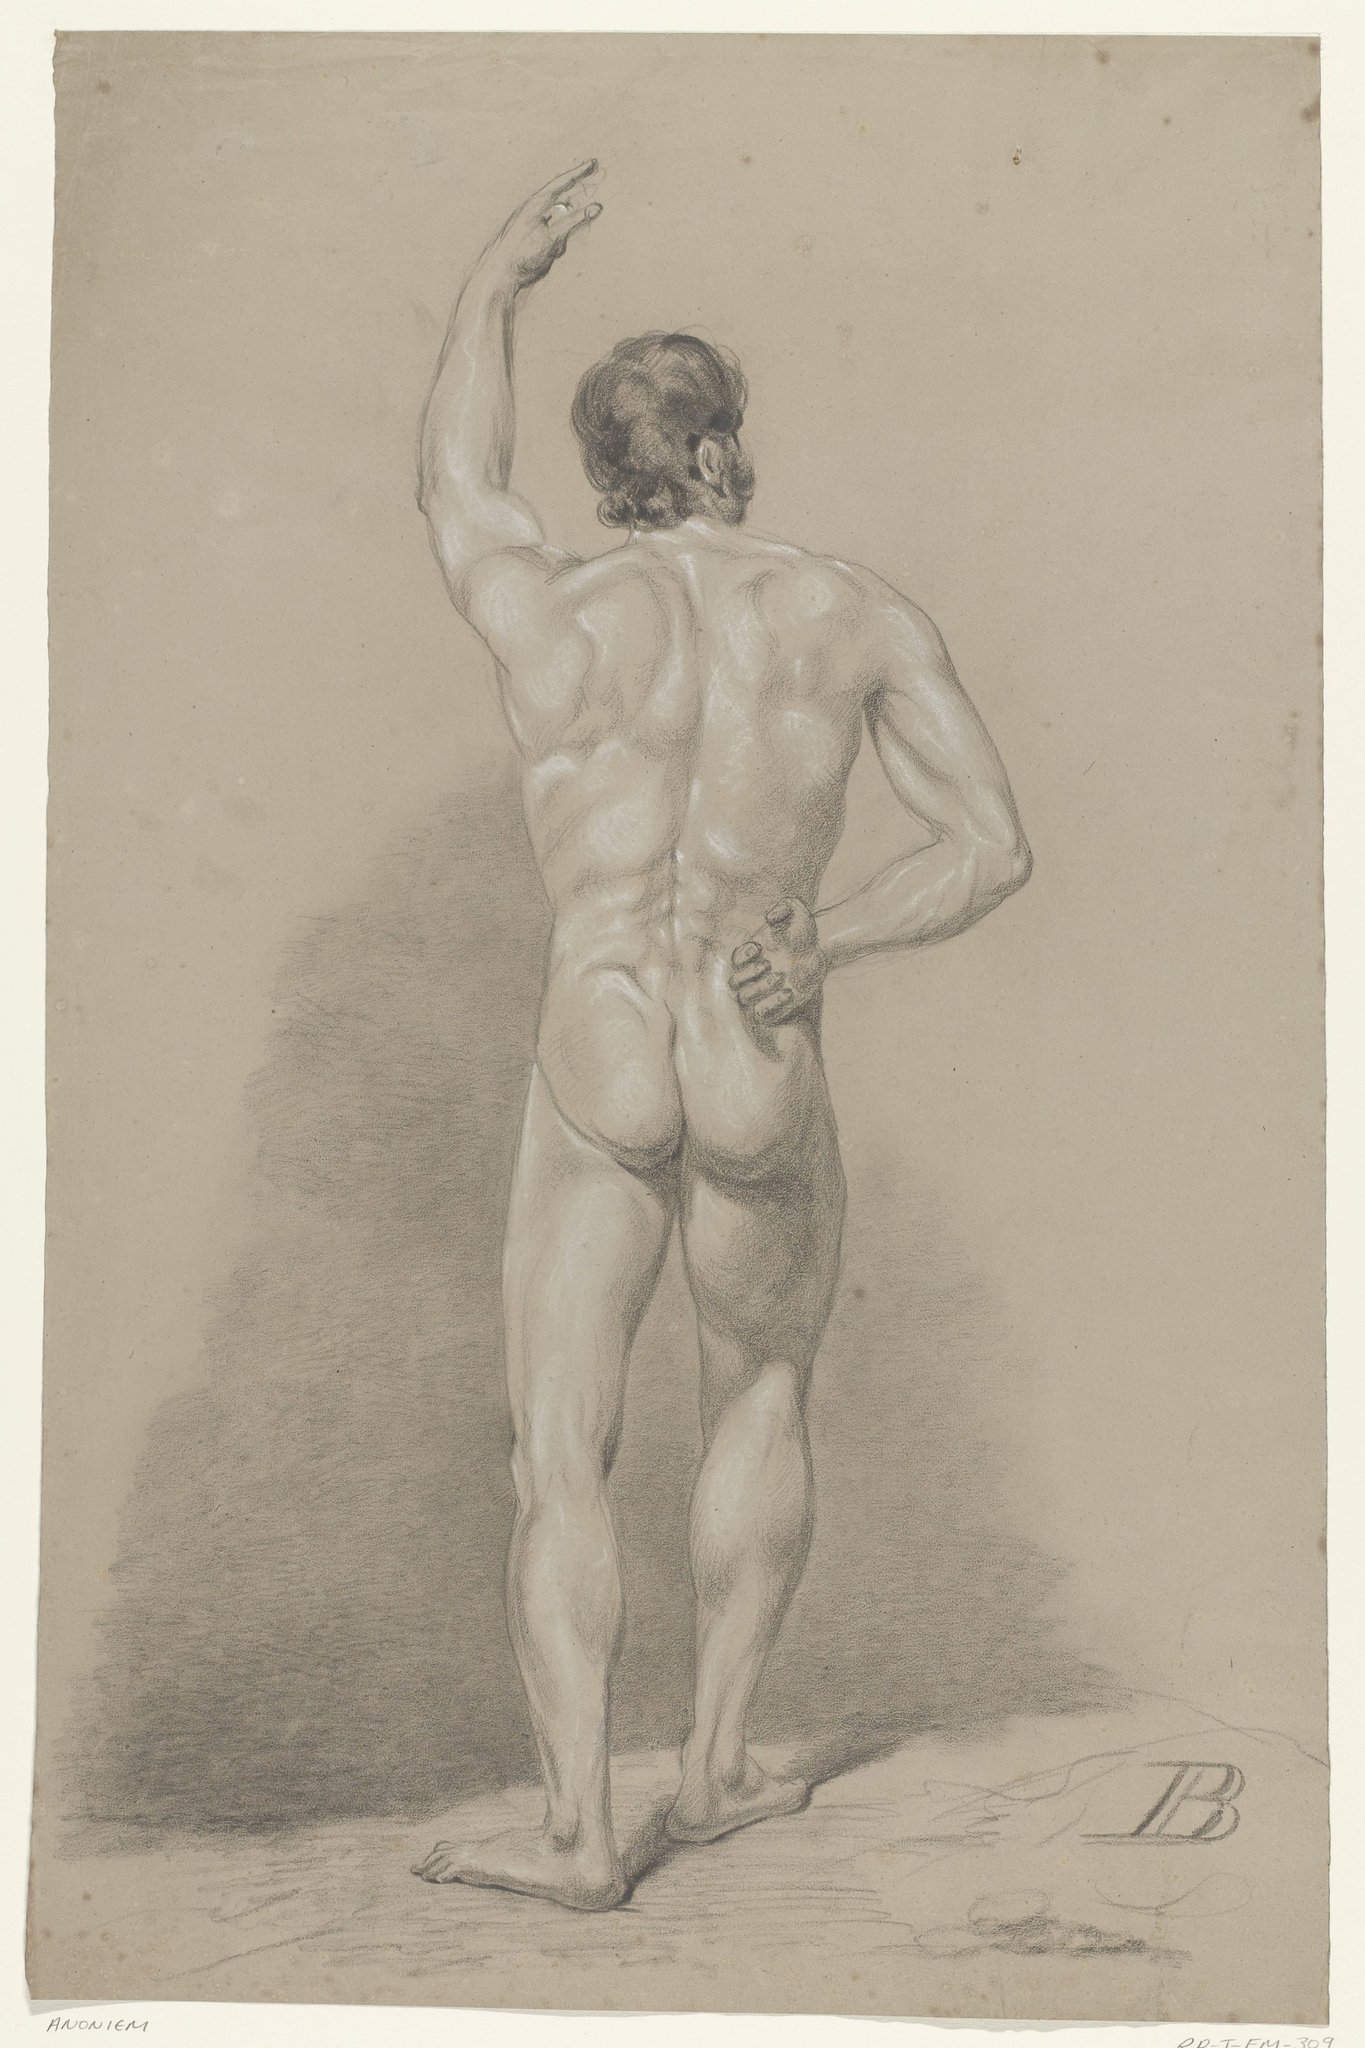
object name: drawing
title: Staand mannelijk naakt met opgeheven arm, van achteren gezien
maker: Anonymous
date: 1840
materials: chalk, paper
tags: standing figure